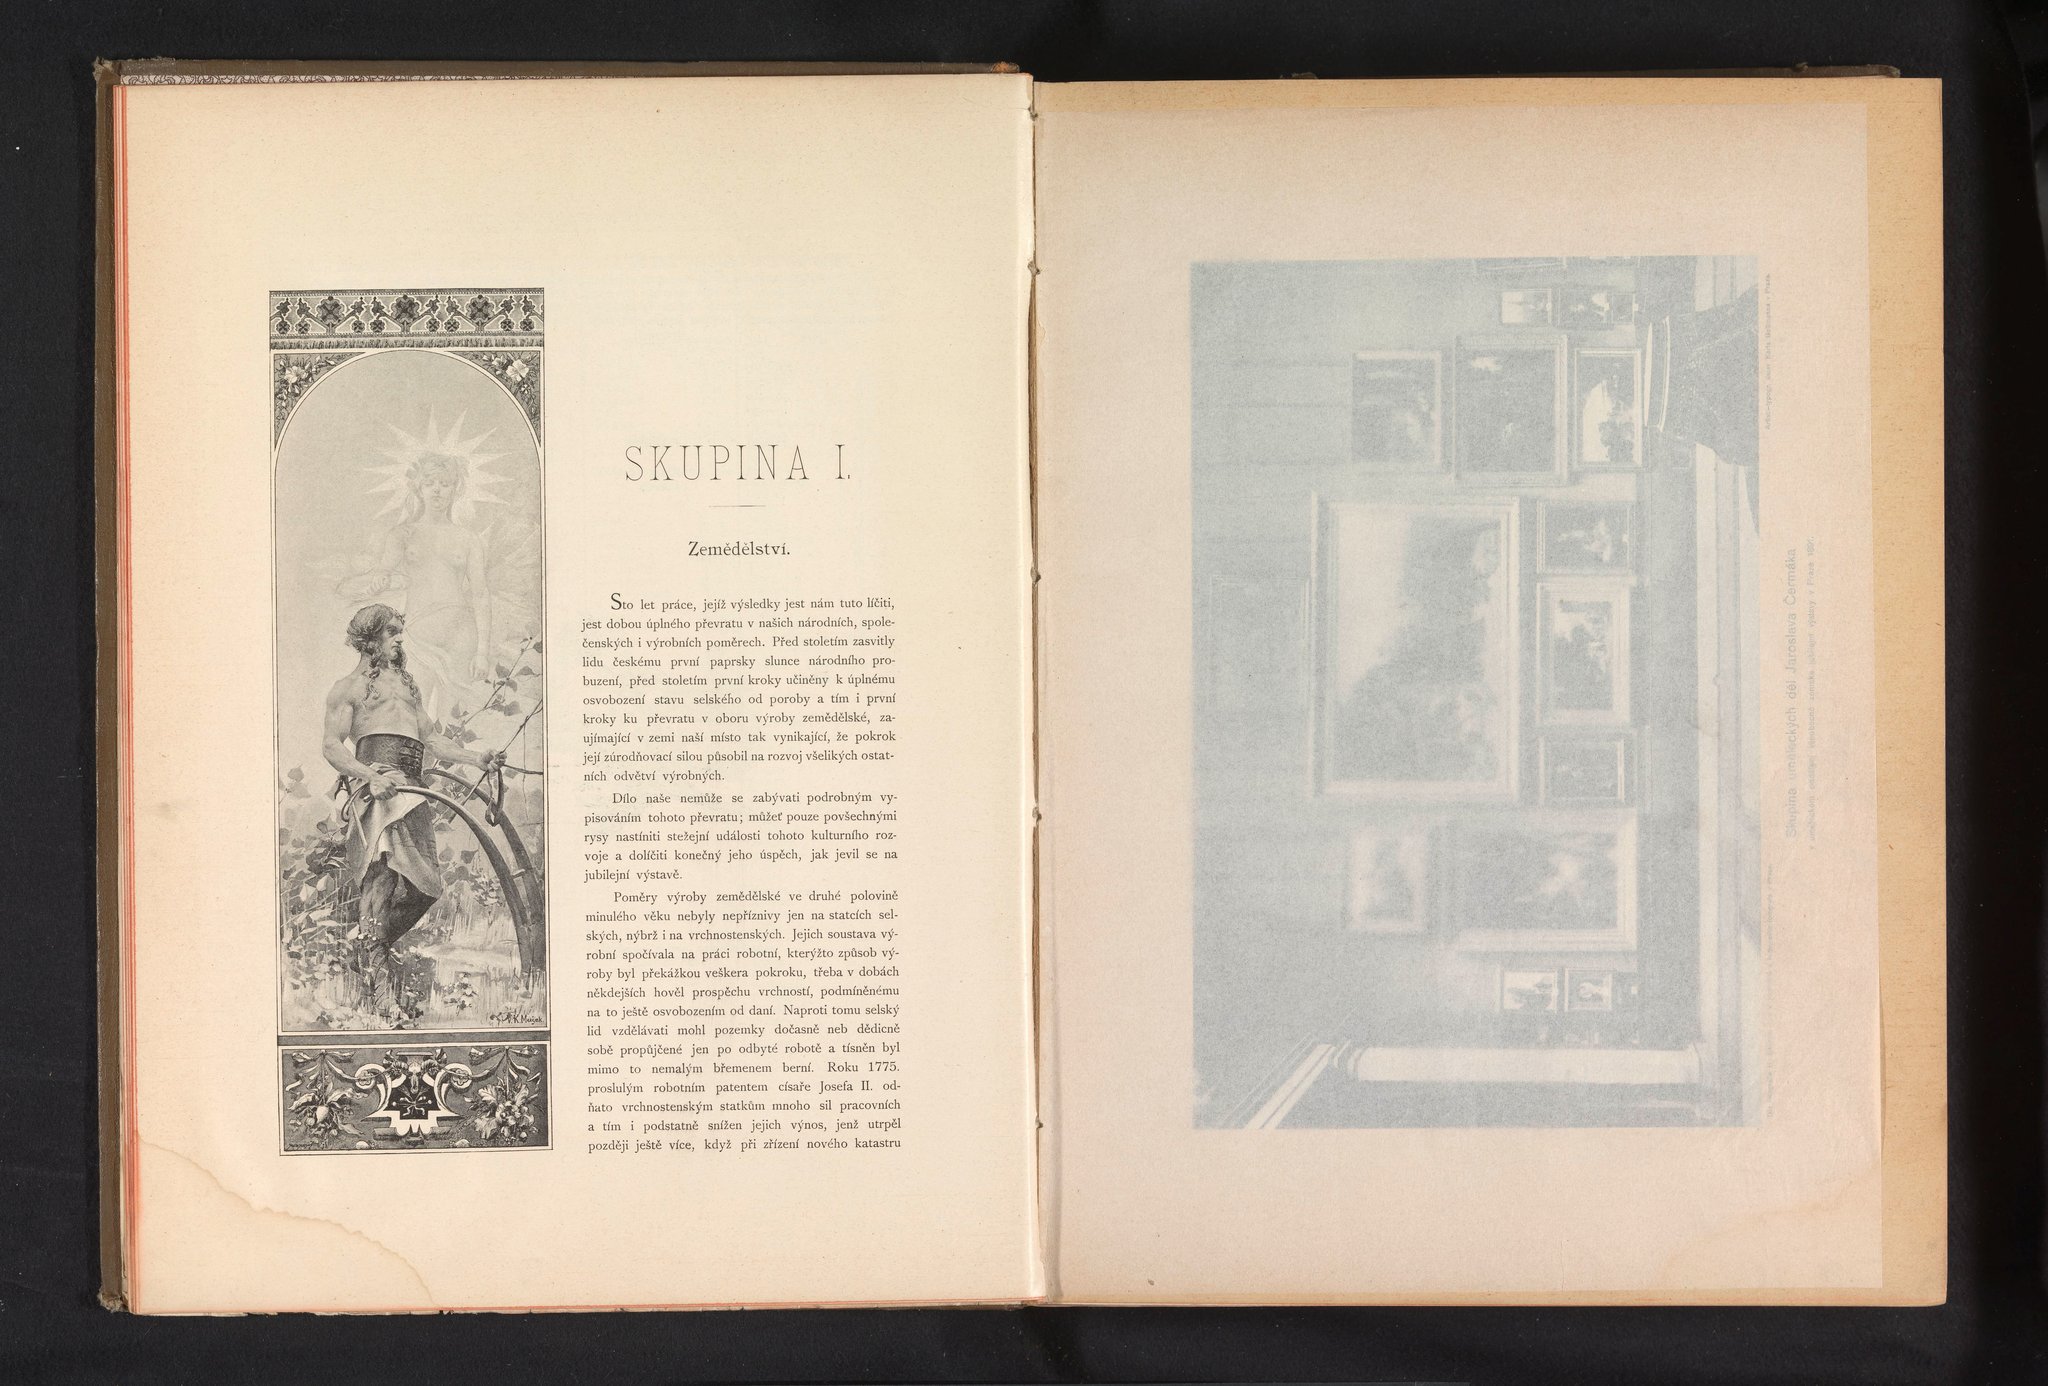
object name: photomechanical print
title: Fotoreproductie van een tekening, voorstellende een boer met een handeg met (vermoedelijk) een personificatie van de Landbouw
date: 1888-1895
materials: paper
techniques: autotype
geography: prague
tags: farmers, agriculture, agricultural implements: harrow